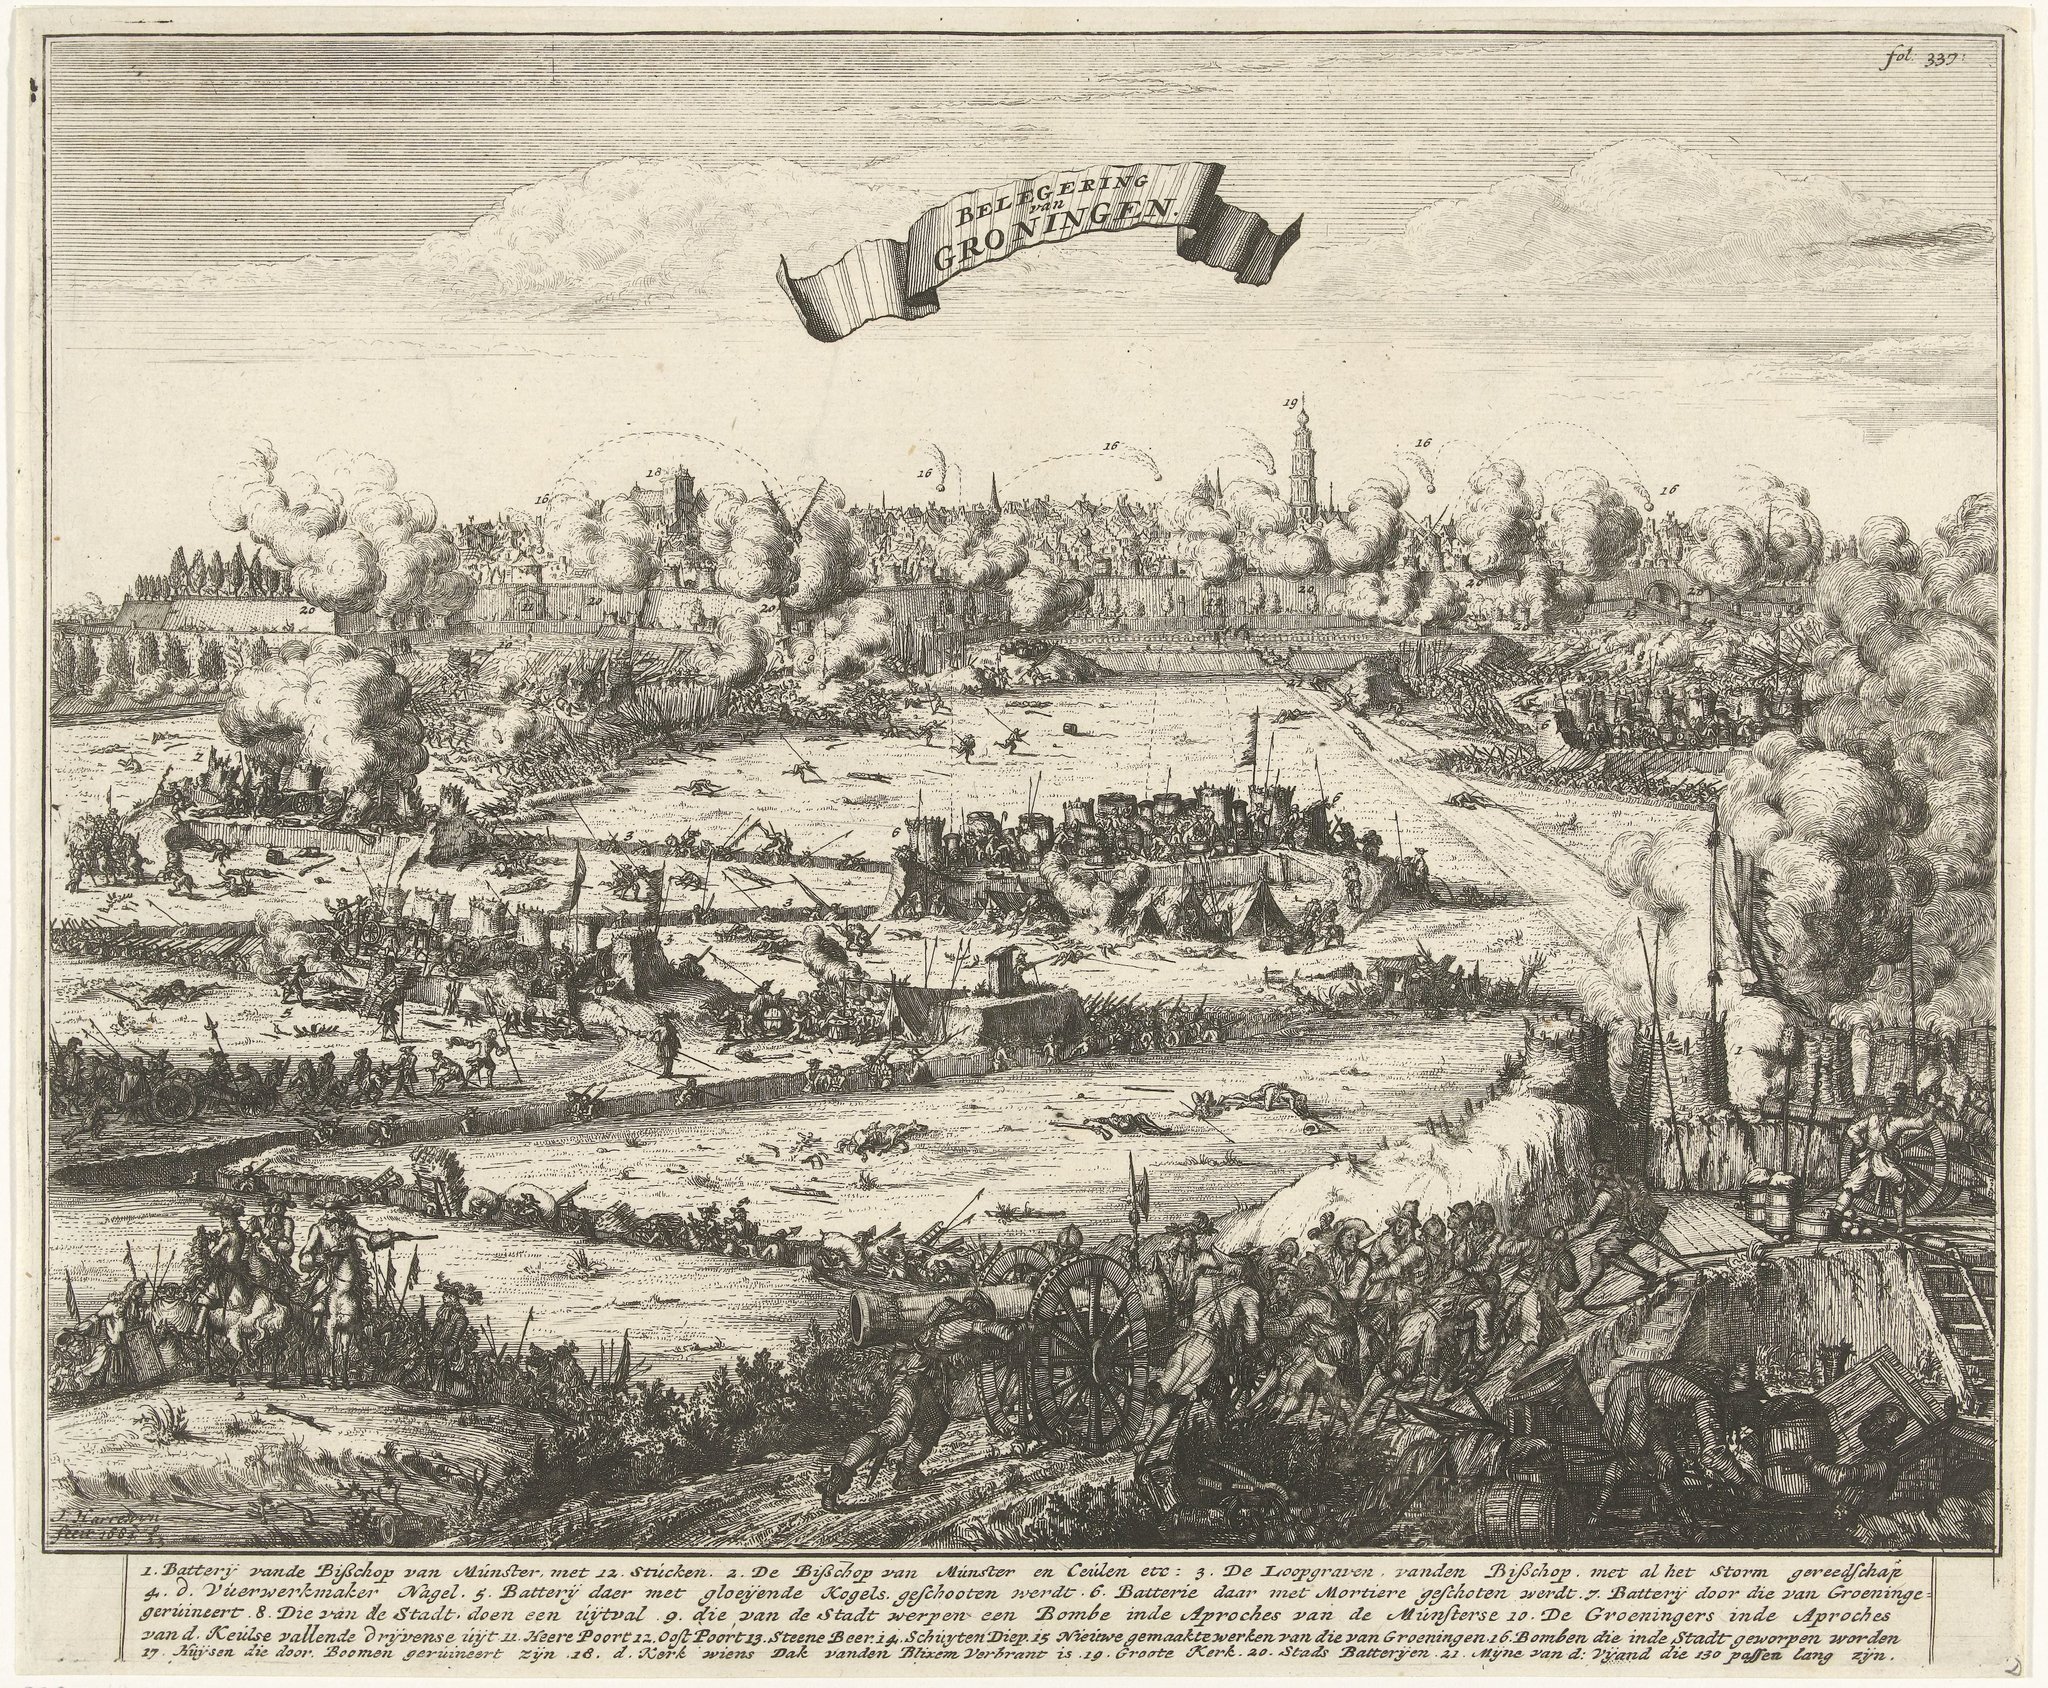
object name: history print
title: Belegering van Groningen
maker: jacobus harrewijn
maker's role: print maker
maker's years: 1660-1740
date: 1684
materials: paper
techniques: etching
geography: low countries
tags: maximiliaan hendrik van beieren, siege, position war, firearms: cannon, (military) attack, trenches (+ during the battle), bombardment (+ land forces)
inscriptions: collector's mark: Lugt 2228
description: De belegering van de stad Groningen door de bisschoppen van Keulen en Münster tussen 12 juli en 17 augustus 1672. Op de voorgrond het slagveld. Aan de horizon de stad Groningen waarop kanonskogels worden afgevuurd. Onderaan een legenda in het Nederlands met de cijfers 1- 21. Bovenaan de titel op een lint. Rechtsboven: fol. 337.